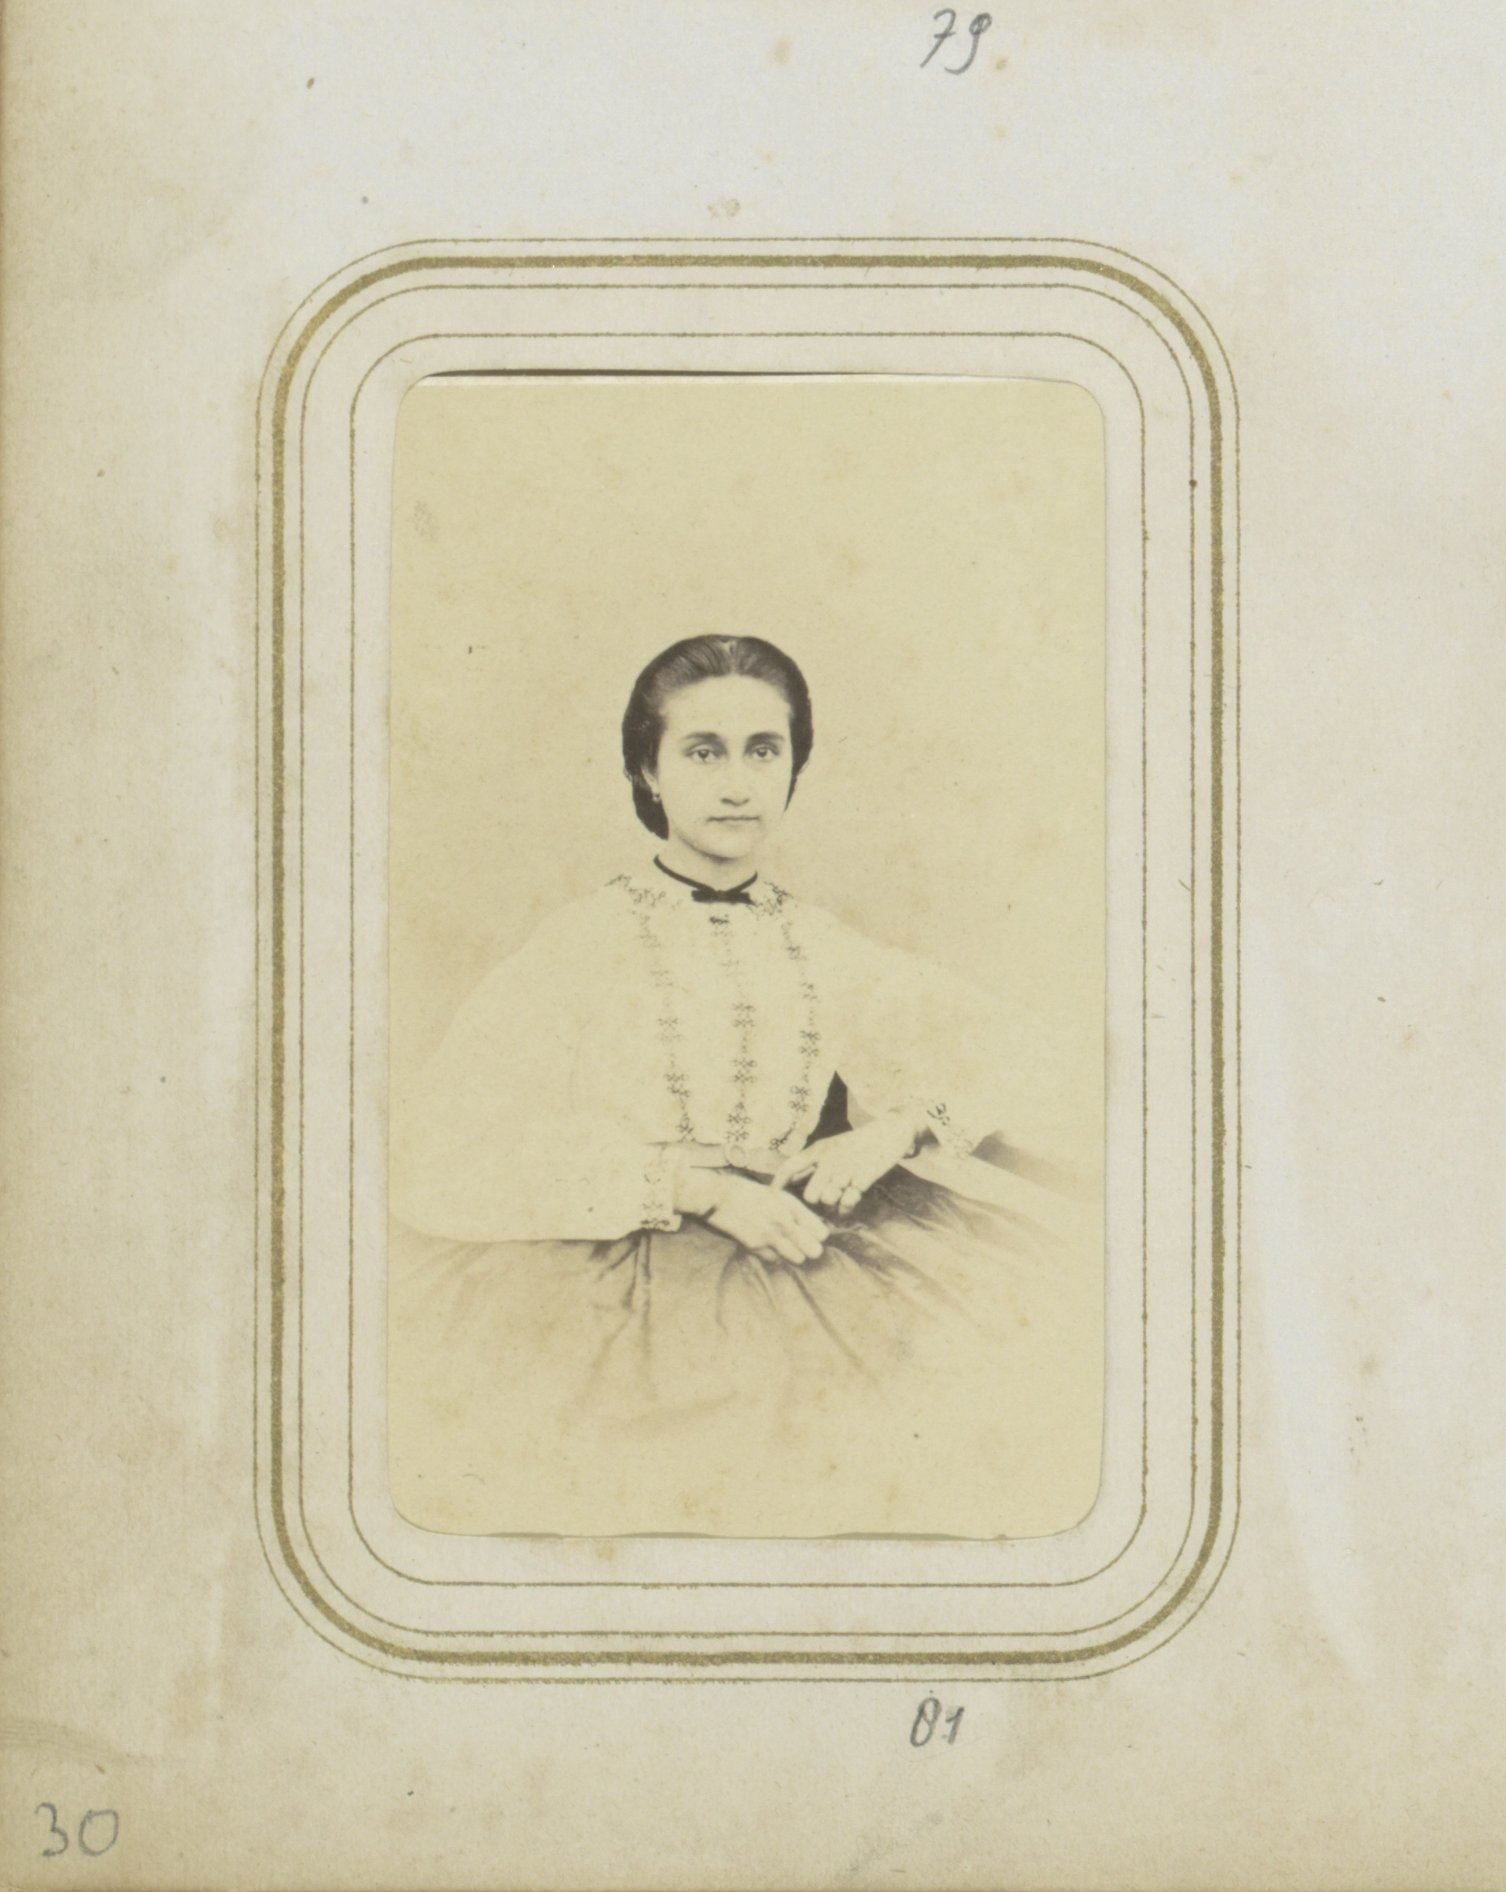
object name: carte de visite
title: Portret van een vrouw met een witte blouse en opgestoken haar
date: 1860-1880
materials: cardboard, photographic support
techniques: albumen print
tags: clothing for the upper part of the body: blouse (+ women's clothes), historical persons, styles of hairdress - aa - ~ women, neck-gear ~ clothing, skirt, family, relationship, descent, netherlands, dutch east indies, the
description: Onderdeel van Familiealbum van H.W.F. Ligtenberg en L.M. Swart met 149 foto's en cartes-de-visite.